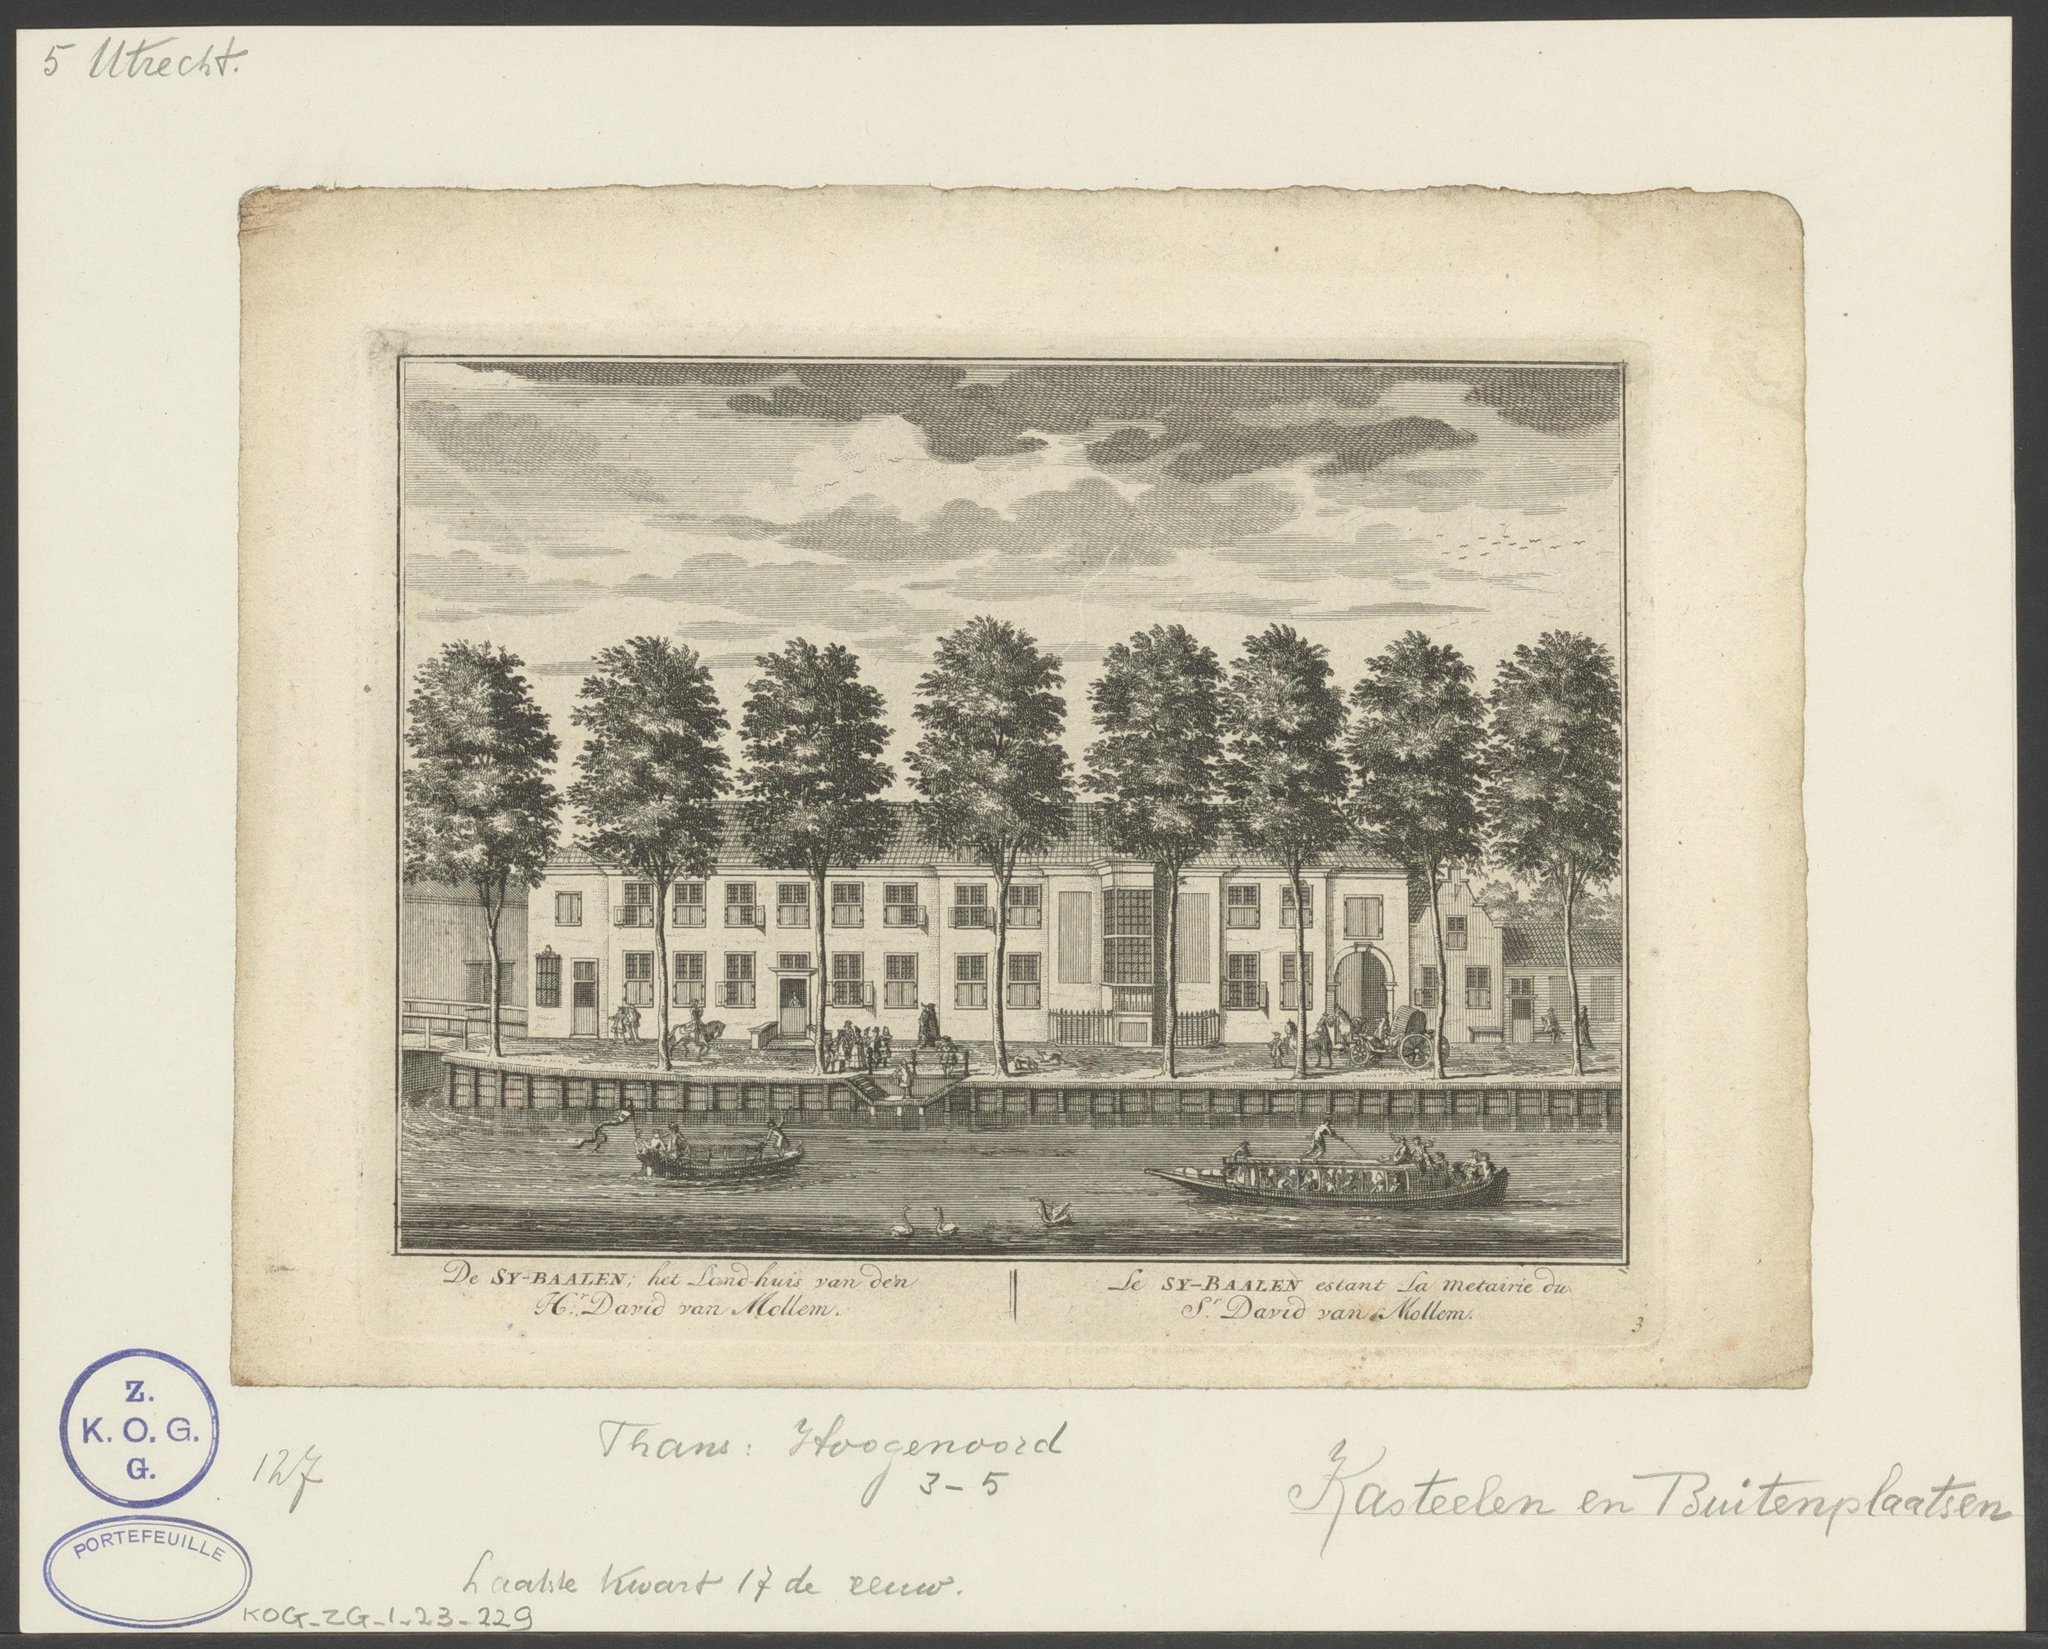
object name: print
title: Gezicht op buitenplaats Zijdebalen aan de Vecht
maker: daniël stopendaal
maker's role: print maker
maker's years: 1672-1726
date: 1790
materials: paper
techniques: engraving, etching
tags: river, textile industry and clothing industry, vecht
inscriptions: collector's mark: Lugt 1641, stamp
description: Rechtsonder genummerd: 3. Onderwerpsrubrieken binnen de Atlas Zeden en Gewoonten: Zeden en gewoonten in Engeren zin, De woning, Kastelen en buitenplaatsen.